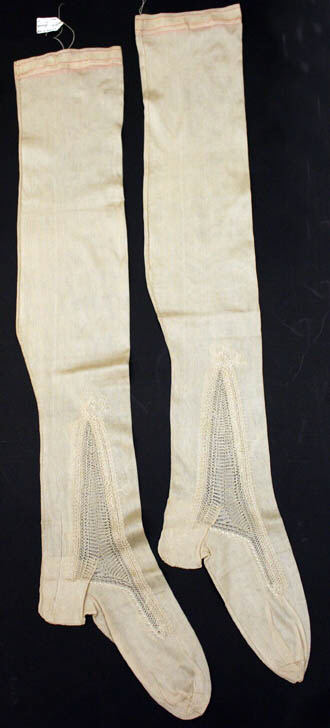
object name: stocking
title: Stockings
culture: french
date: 1801-1900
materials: silk